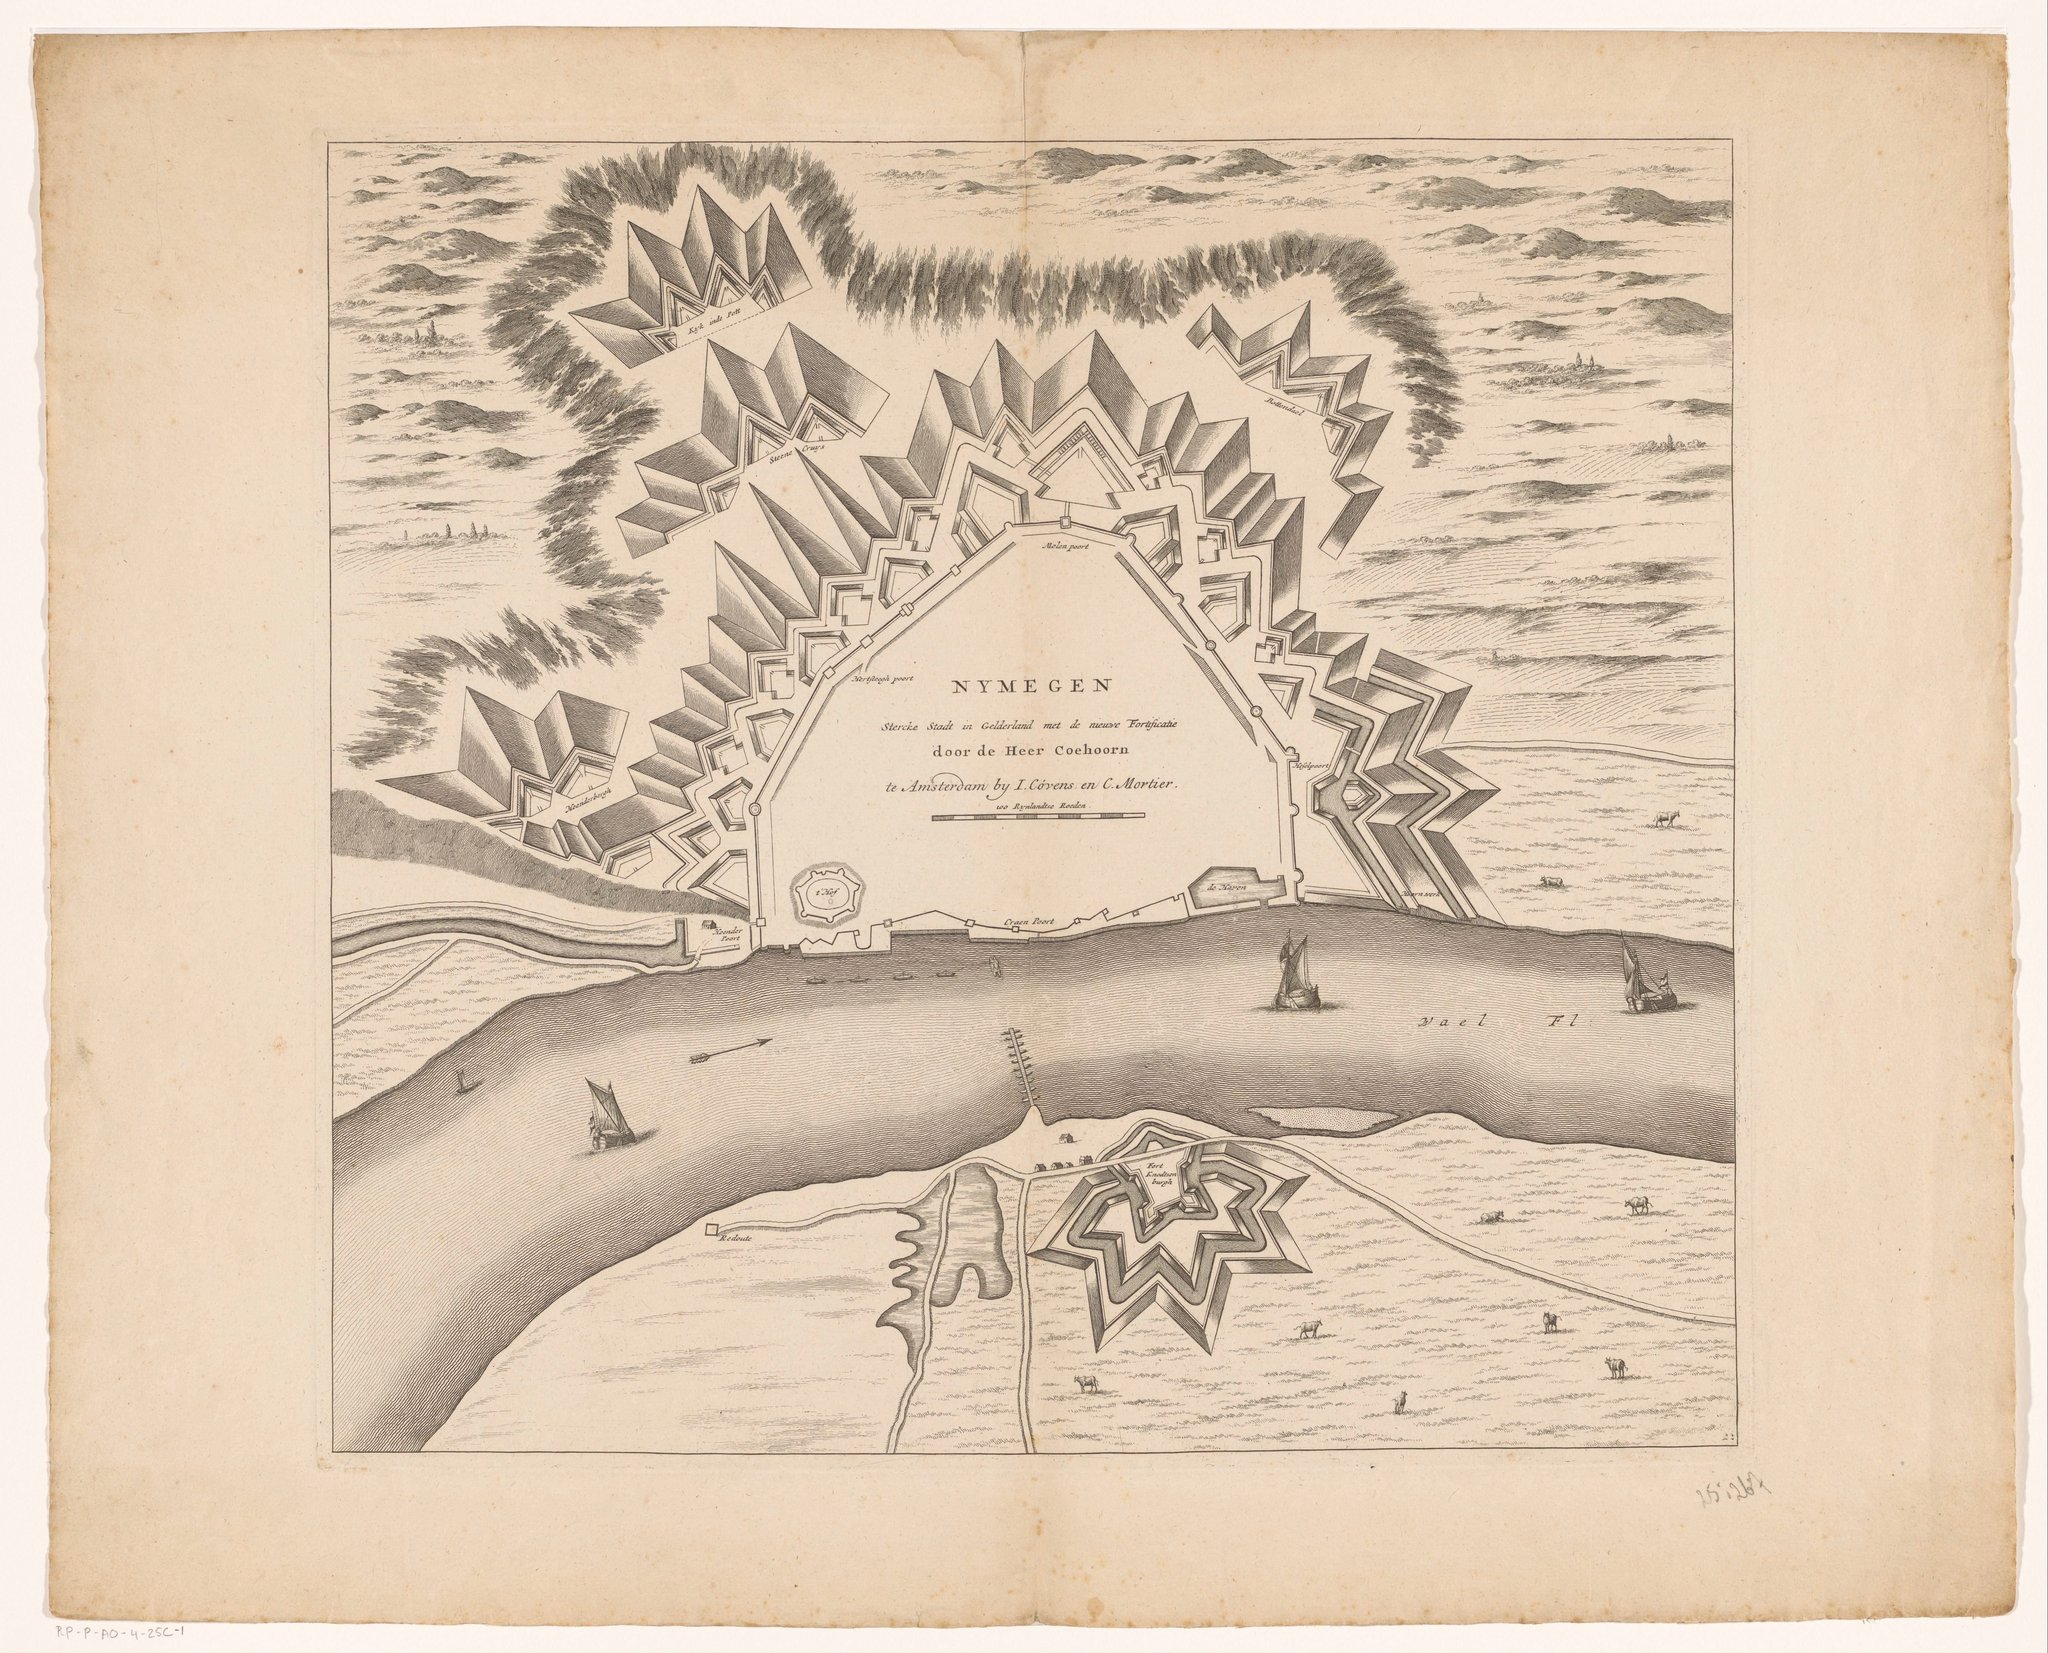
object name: area plan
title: Plattegrond van de fortificaties om Nijmegen ontworpen door Menno van Coehoorn in 1702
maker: Anonymous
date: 1702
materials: paper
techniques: engraving, etching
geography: amsterdam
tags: the hague, fortress, maps of cities, nijmegen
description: Plattegrond van Nijmegen aan de Waal met de geplande nieuwe fortificaties ontworpen door Menno baron van Coehoorn in 1702. In het midden een schaalstok: 100 Rynlandtse roeden.